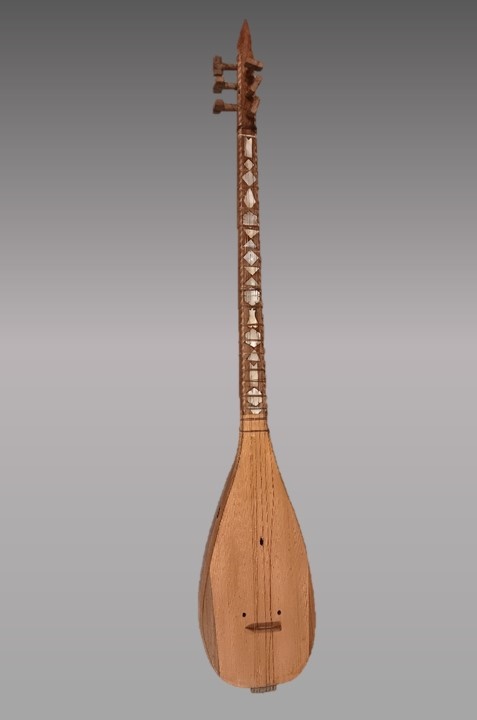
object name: jōra small sāz,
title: Jōra (small) Sāz,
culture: turkish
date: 1867-1900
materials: wood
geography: turkey